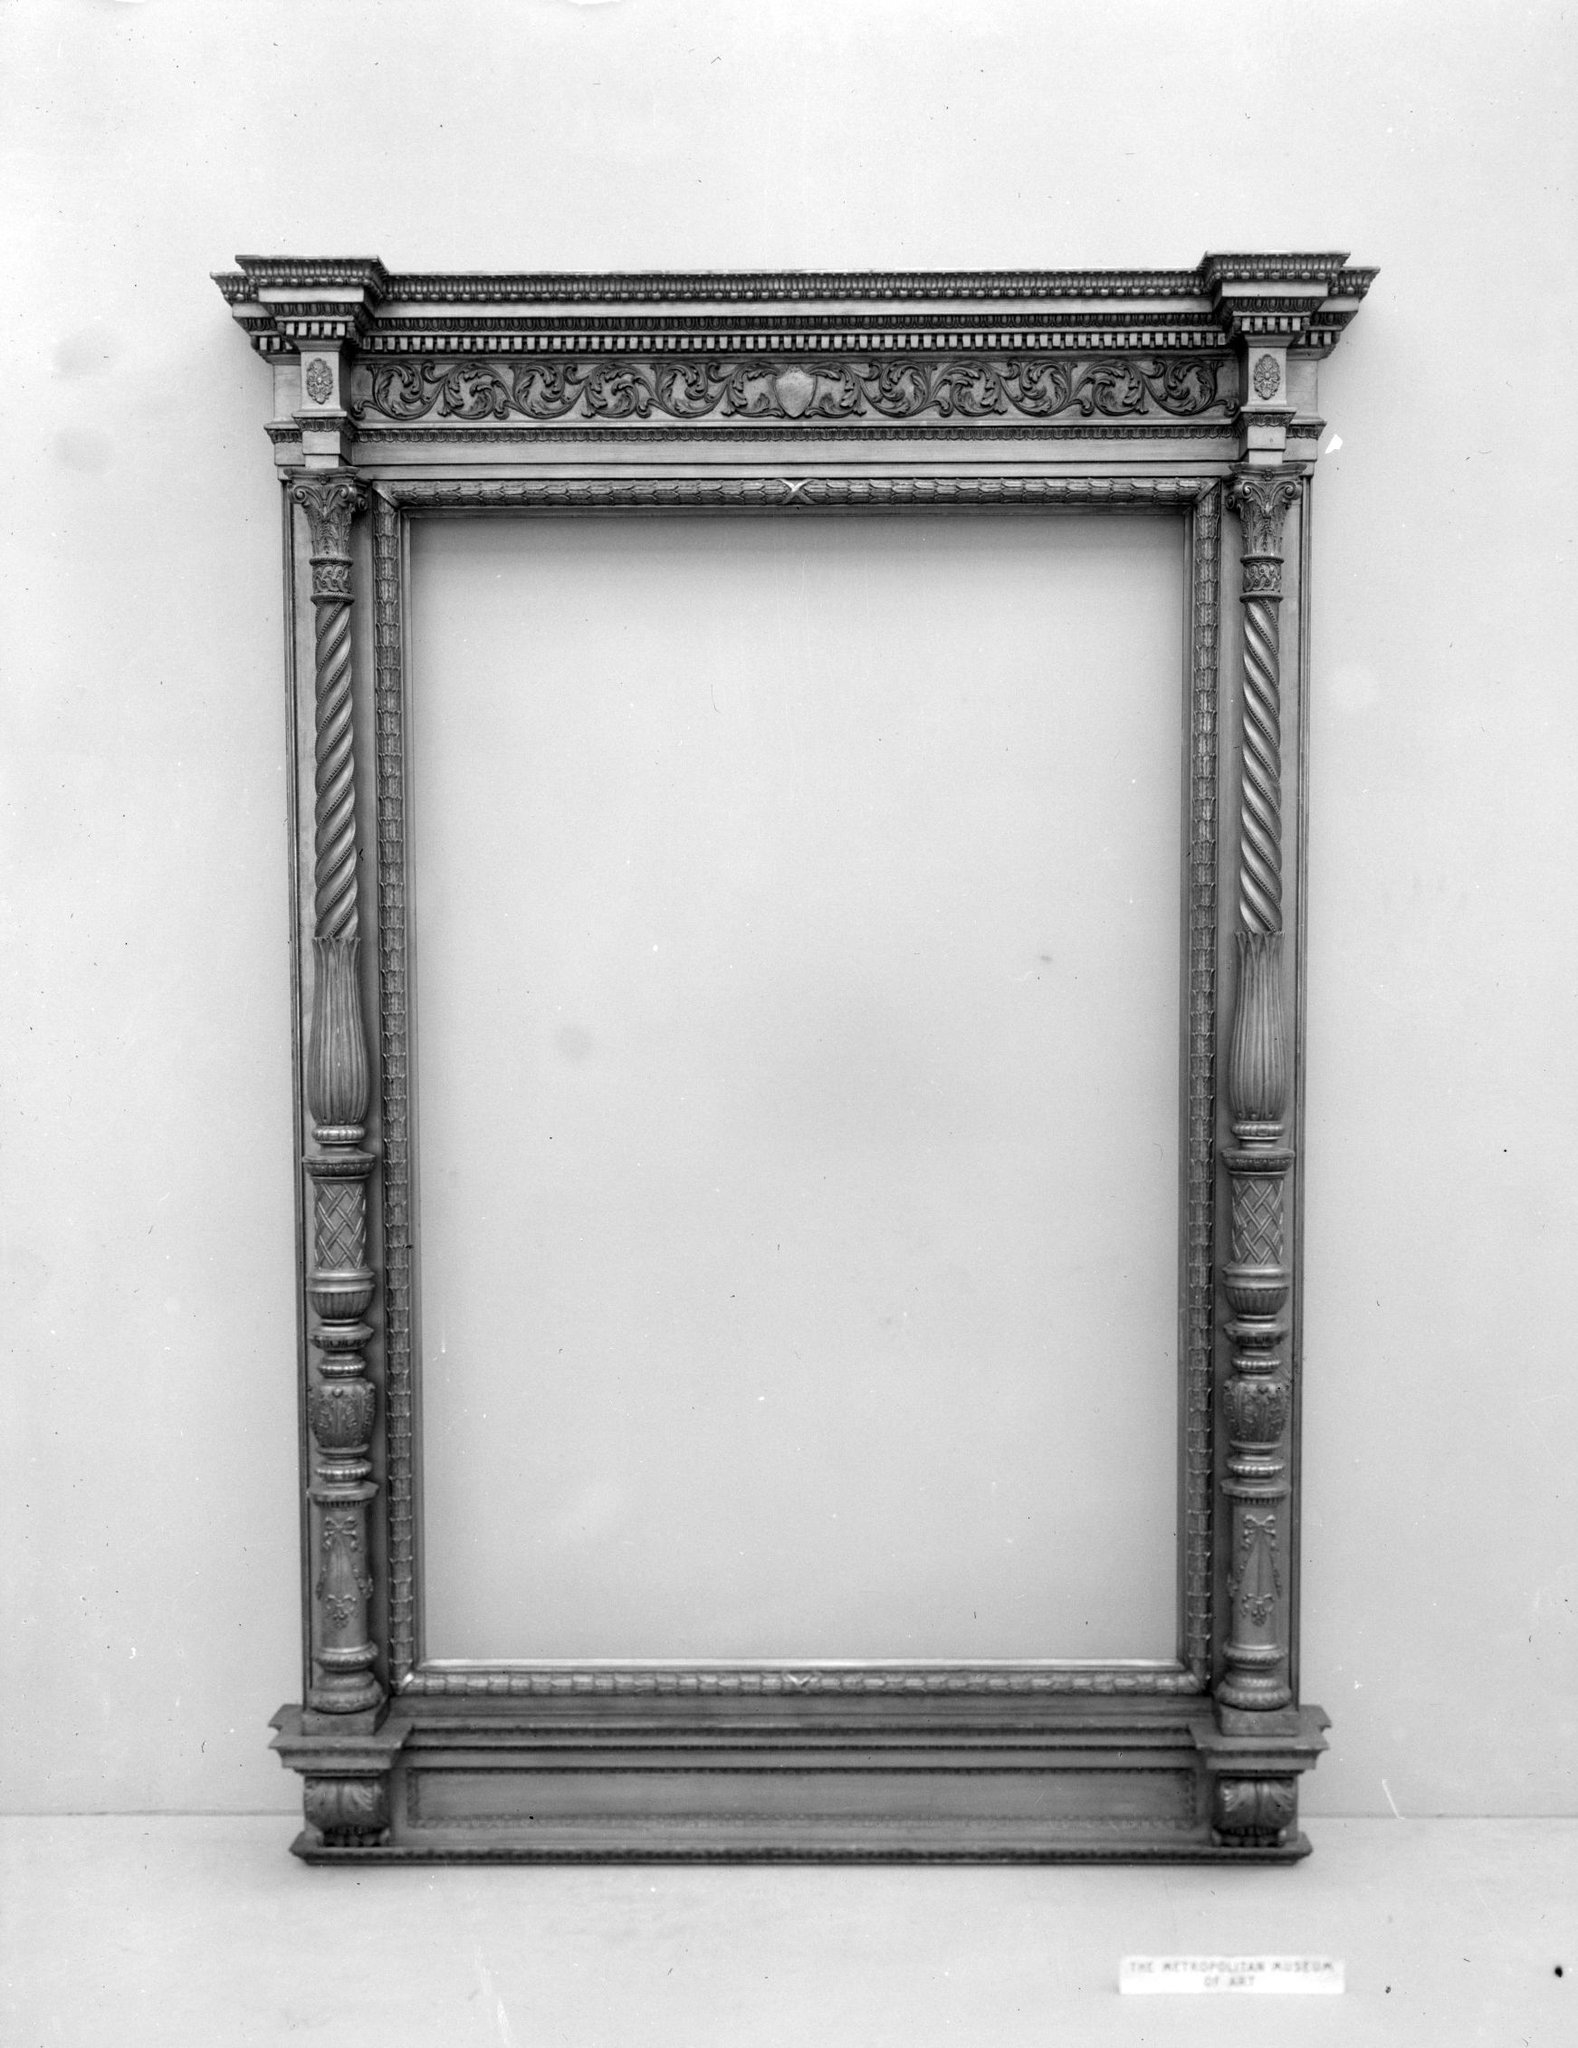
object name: frame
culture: american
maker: stanford white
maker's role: maker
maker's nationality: american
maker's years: 1853-1906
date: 1870-1900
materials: gilt, wood